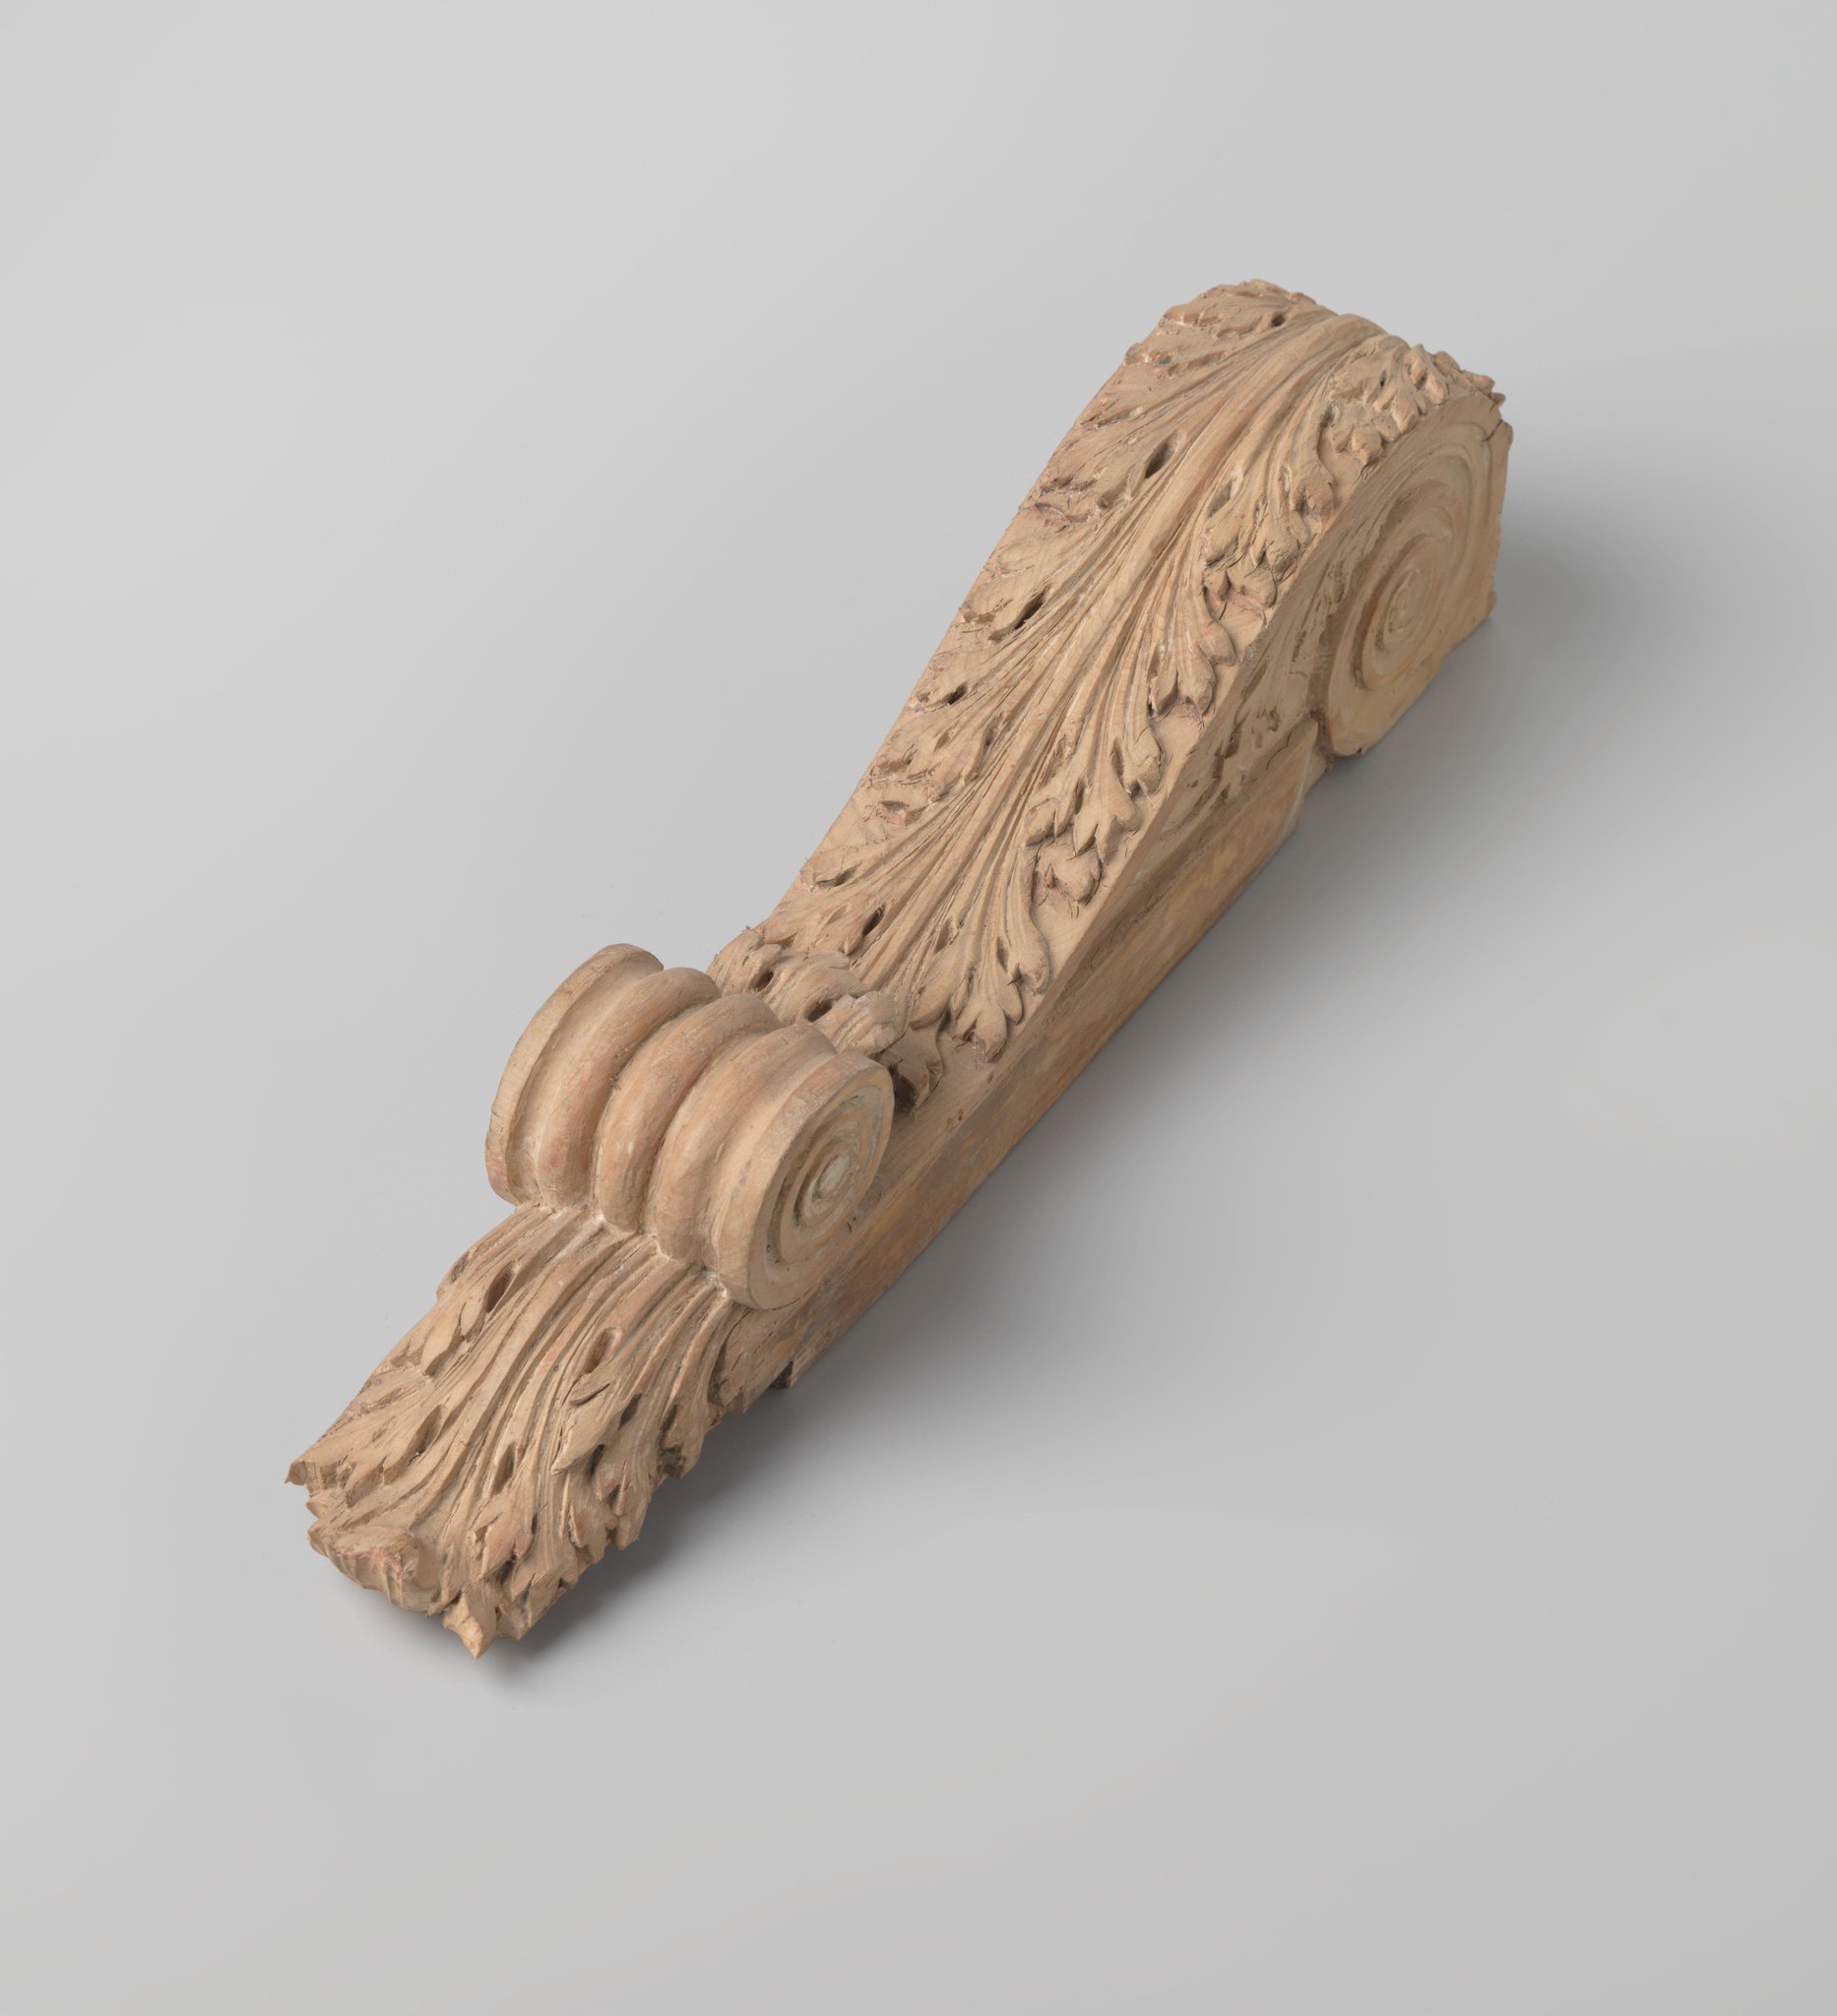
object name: portiek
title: S-voluut behorend bij een portiek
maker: Anonymous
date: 1687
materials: wood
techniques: painted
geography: northern netherlands